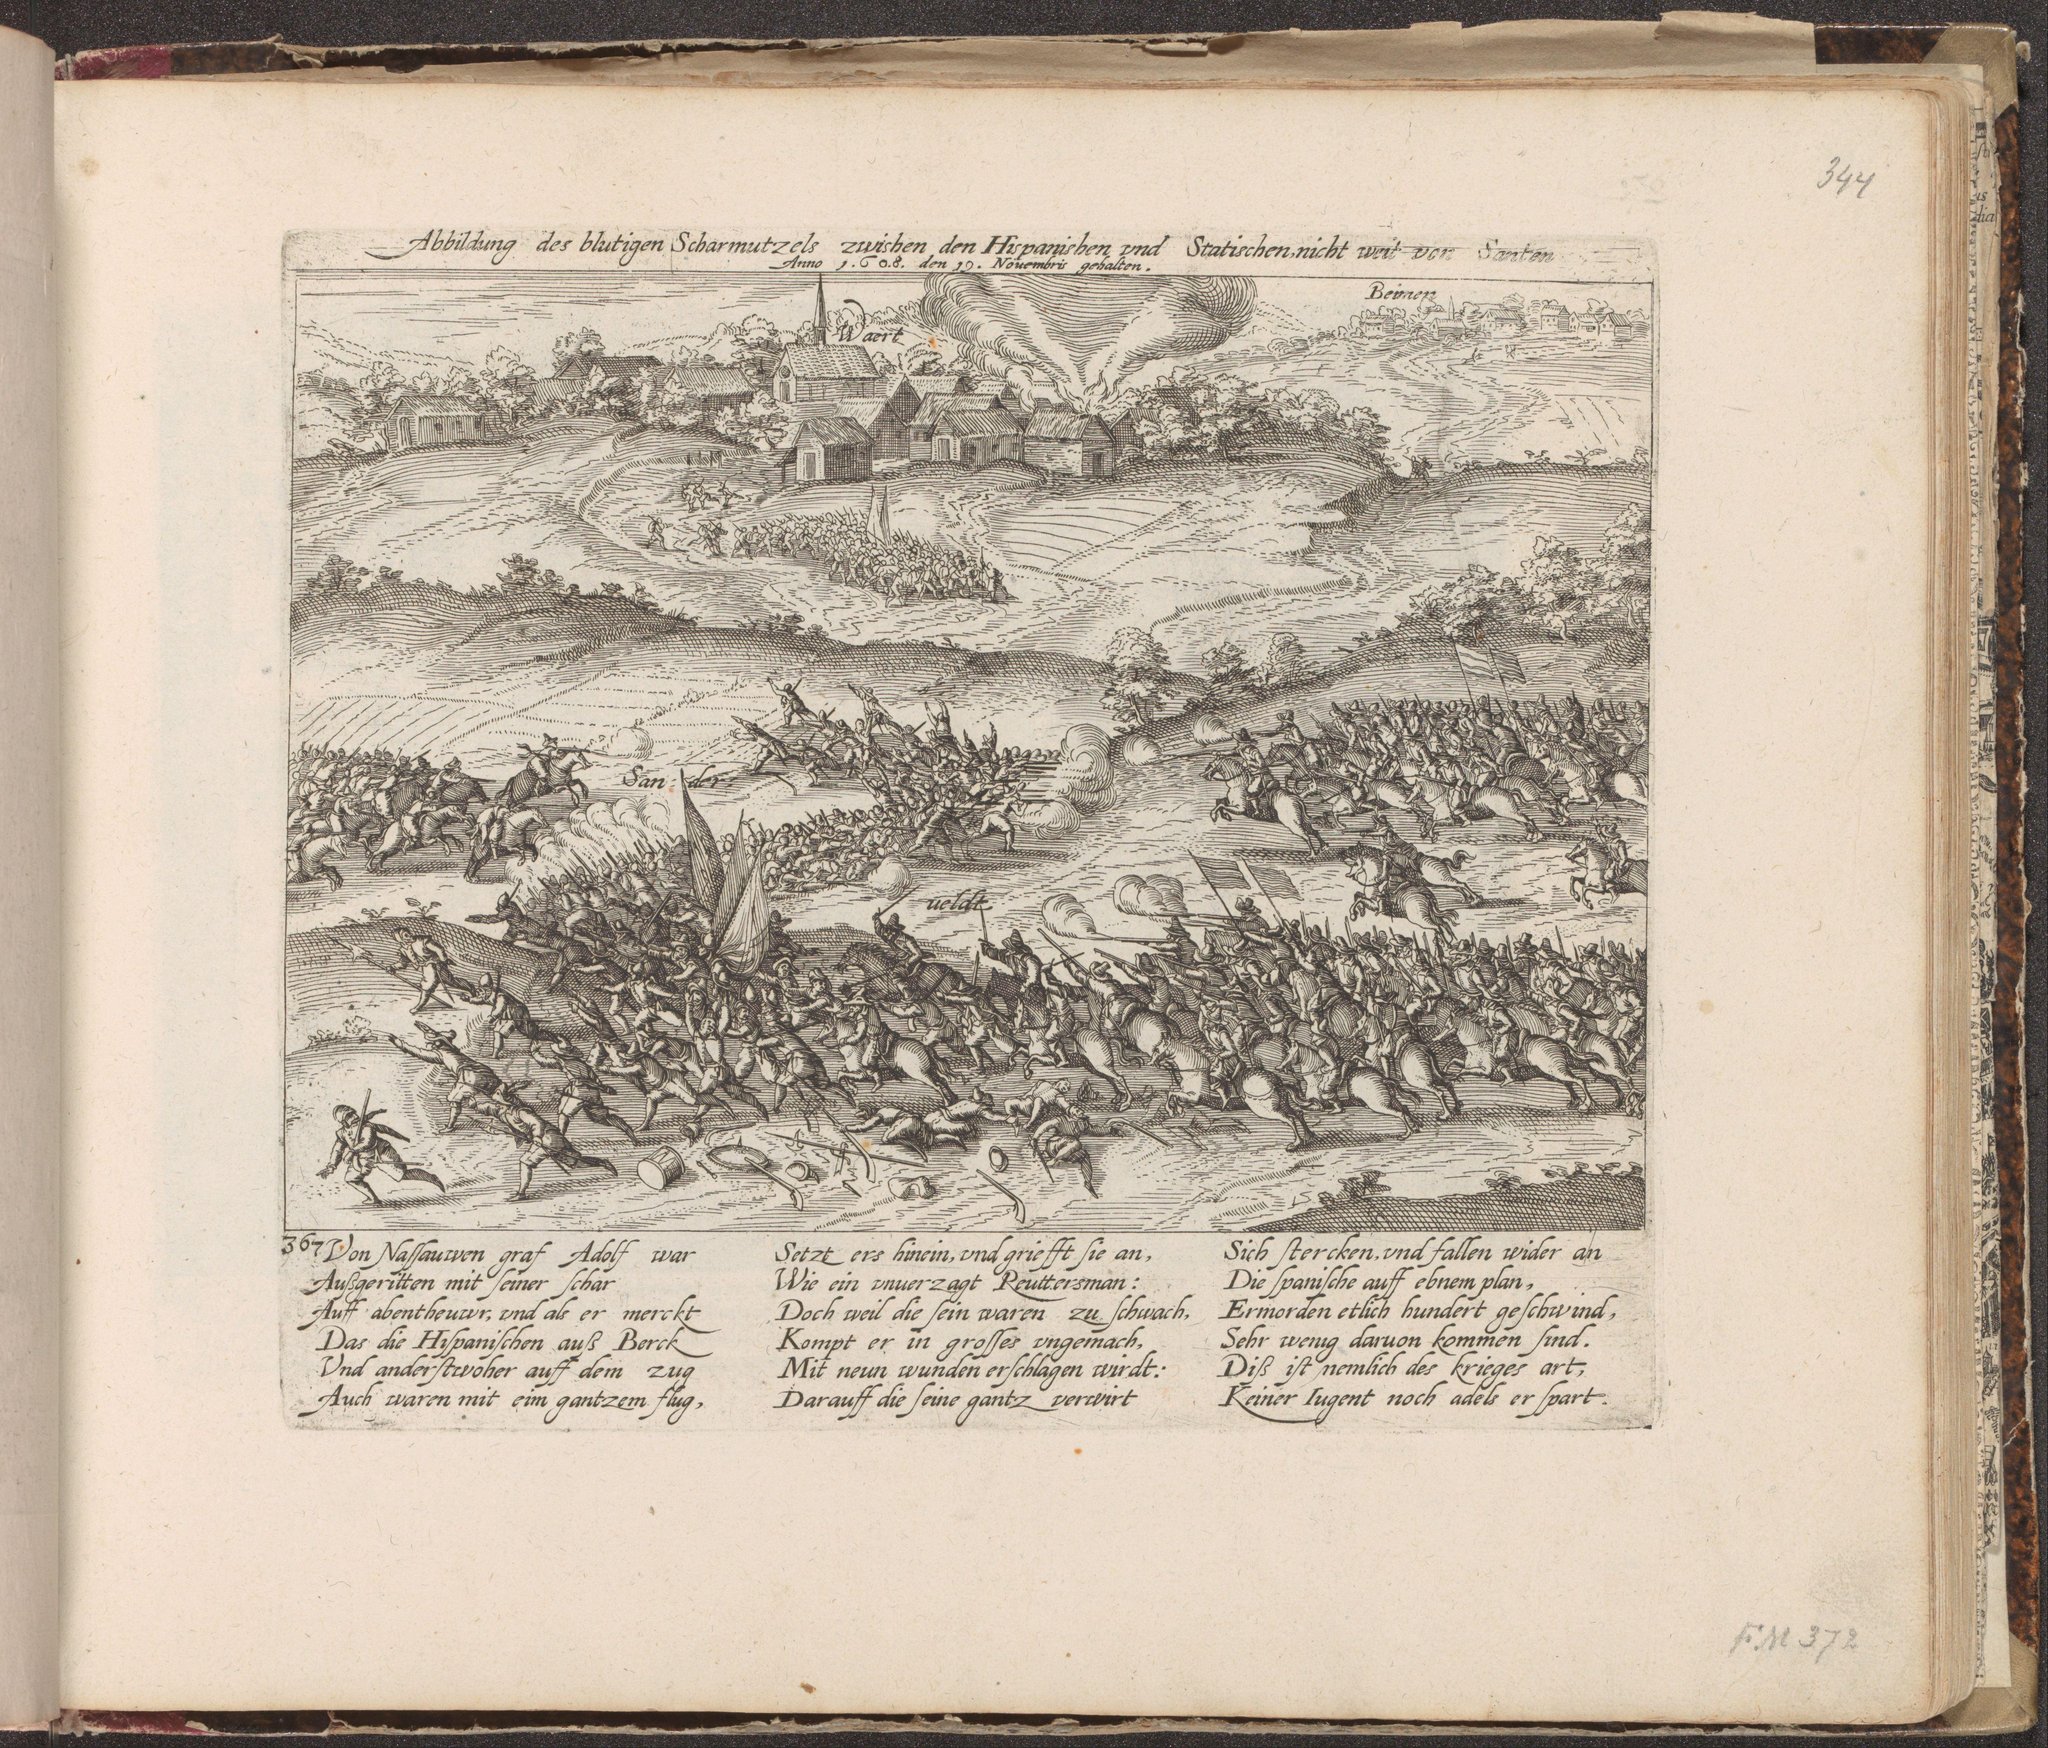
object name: print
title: Slag bij Xanten, 1608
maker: frans hogenberg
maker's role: print maker, publisher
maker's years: 1538-1590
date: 1608-1610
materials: paper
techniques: etching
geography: cologne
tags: battle, fighting in general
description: Veldslag bij Wardt, nabij Xanten, 19 november 1608. Met onderschrift van 18 regels in het Duits. Linksonder genummerd: 367. De prent maakt deel uit van een album.